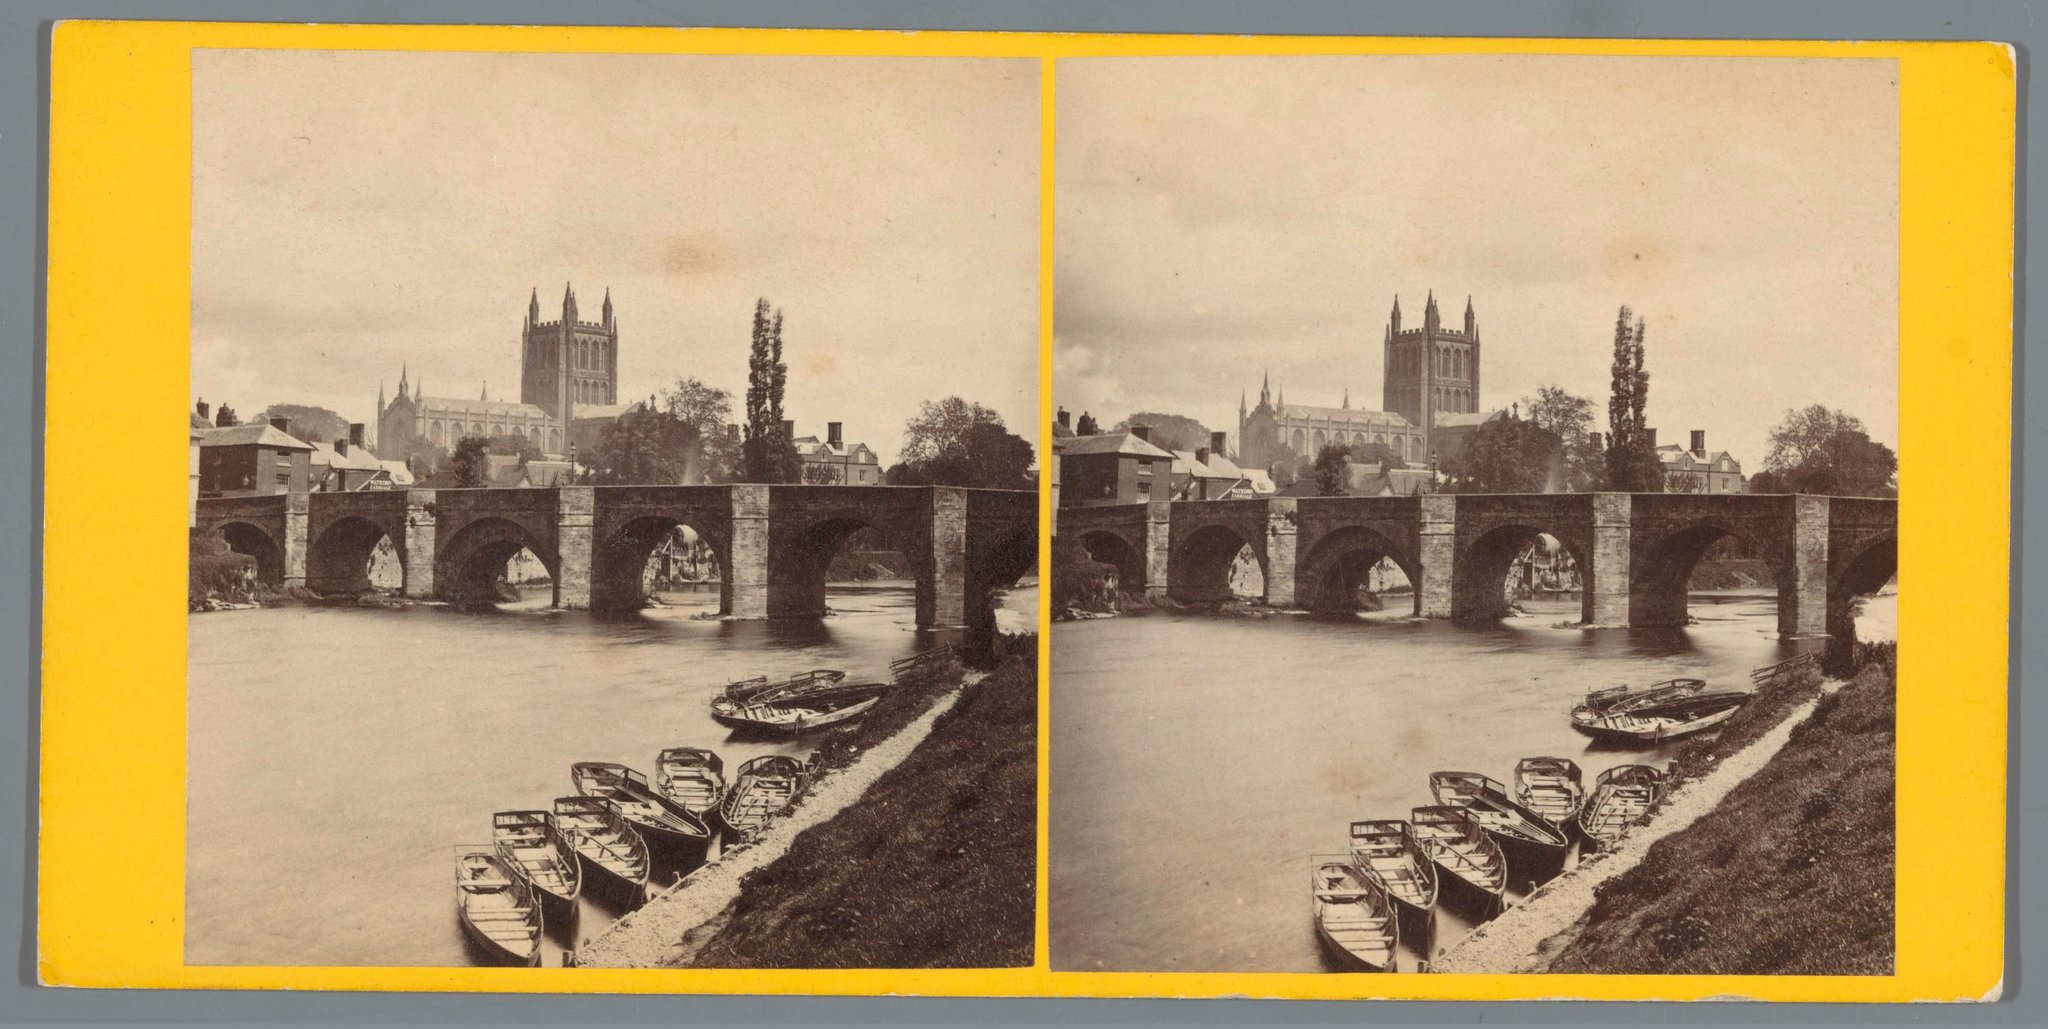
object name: stereograph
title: Hereford Cathedral and Bridge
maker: george washington wilson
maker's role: publisher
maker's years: 1823-1893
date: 1860-1865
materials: cardboard, photographic support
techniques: albumen print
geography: aberdeen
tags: schotland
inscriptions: label: ‘G.W. Wilson & Co, Aberdeen No. 1175 Hereford Cathedral and Bridge’